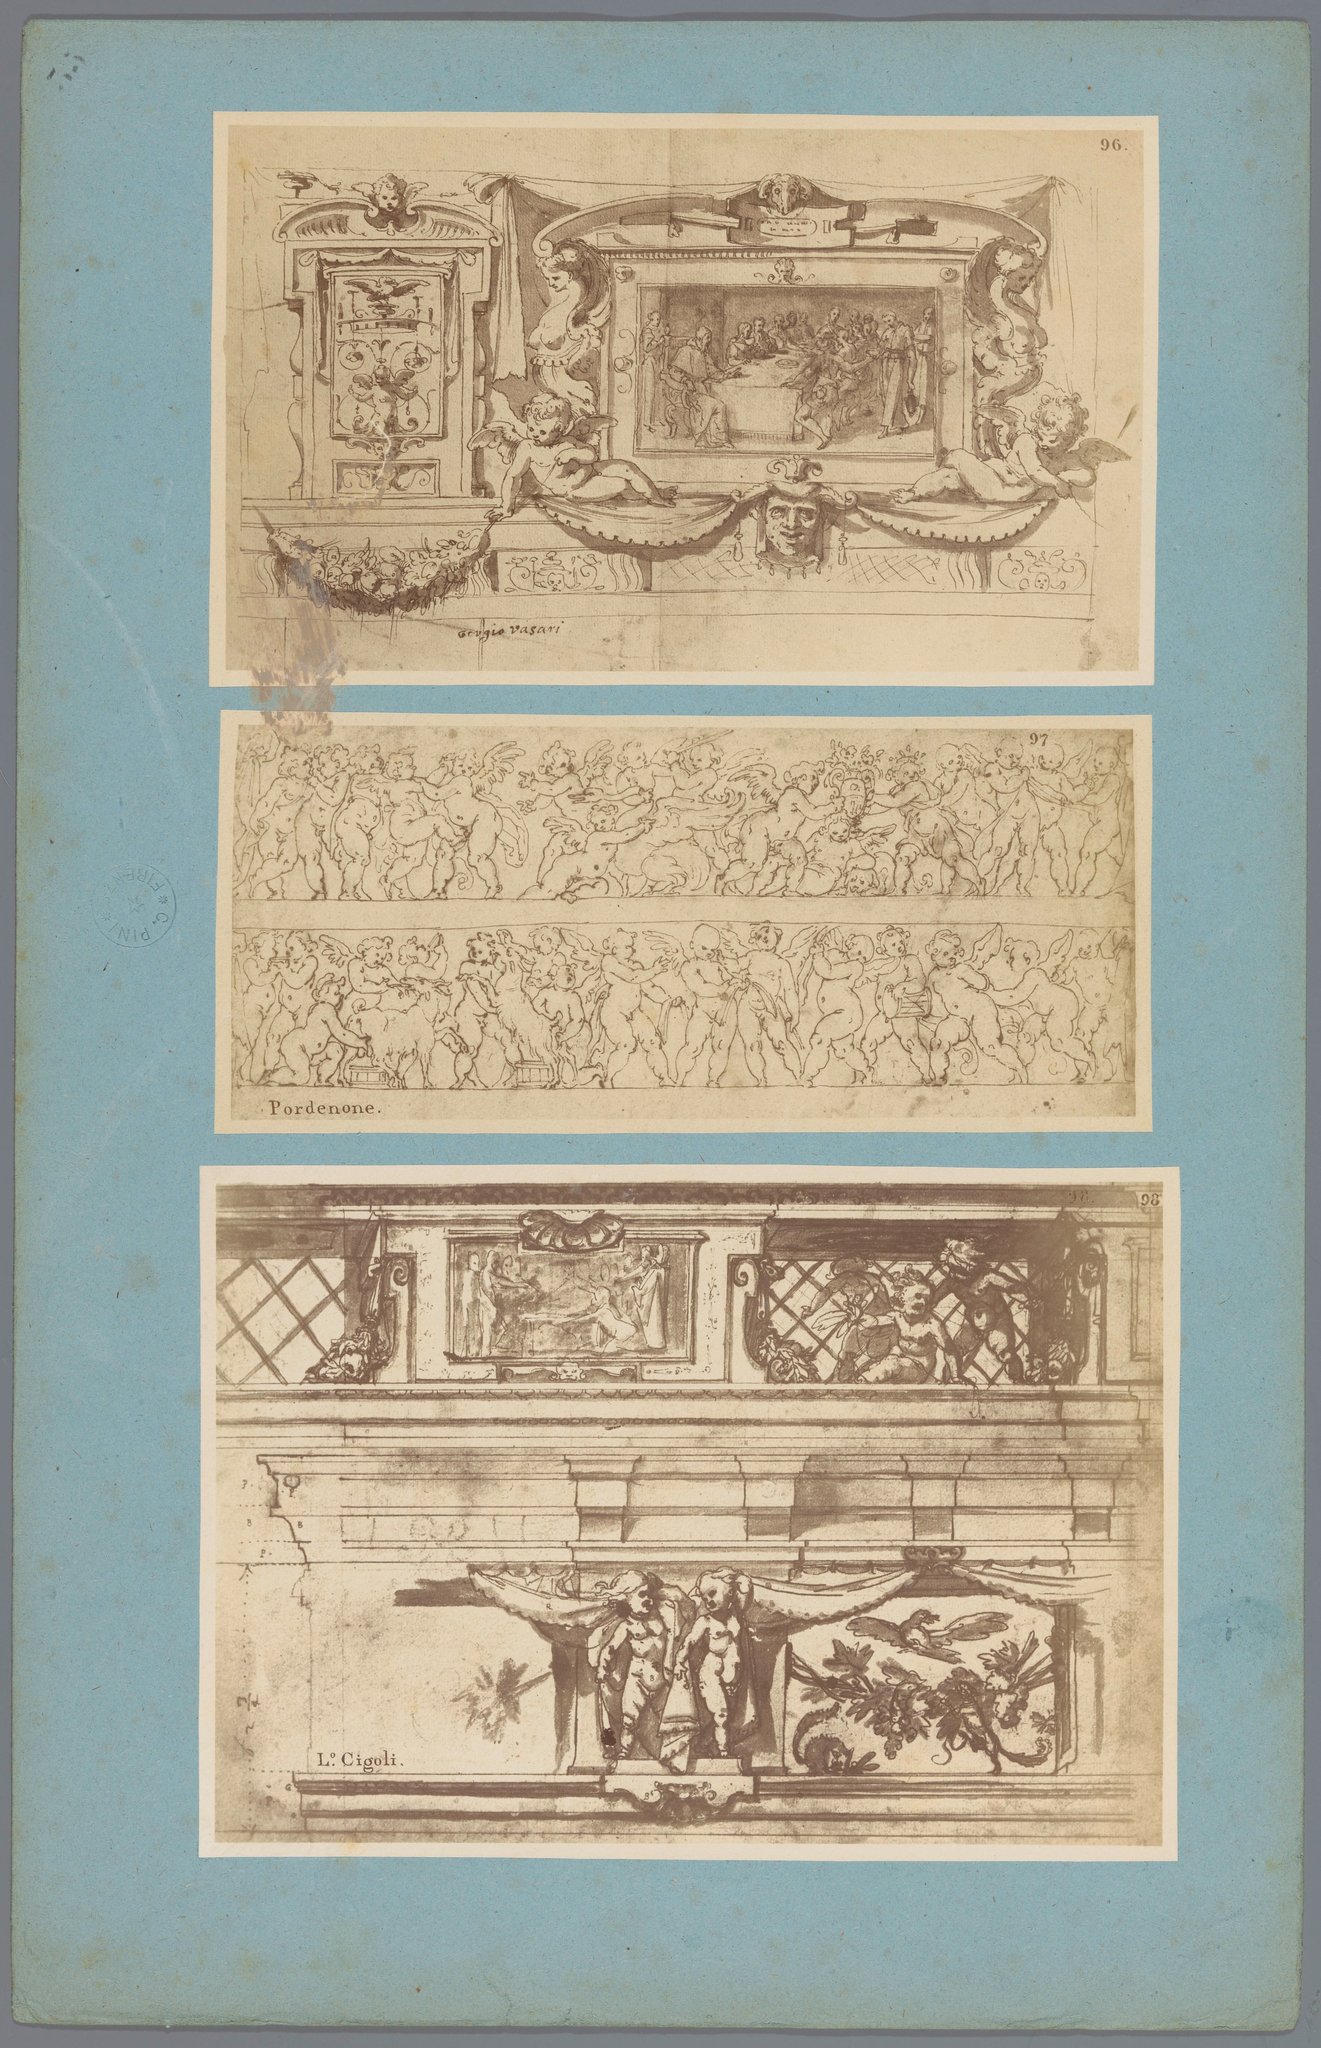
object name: photograph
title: Drie fotoreproducties van tekeningen, vermoedelijk van wanddecoraties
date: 1875-1900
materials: cardboard, photographic support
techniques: albumen print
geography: europe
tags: drawing, sketch, caryatids ~ architecture, cupids: 'amores', 'amoretti', 'putti', europe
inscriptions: name: ‘C. Pini Firenze’, number: ‘[...]’, number: ‘98’, collector's mark: Lugt 3937, number: ‘97’, number: ‘96.’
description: Boven (96) een tekening van een schildering in een geornamenteerde lijst door Giorgio Vasari, midden (97) een tekening van putti met muziekinstrumenten en dieren door Pordenone, onder (98) een tekening van een fries met formaten ernaast door L. Cigoli.